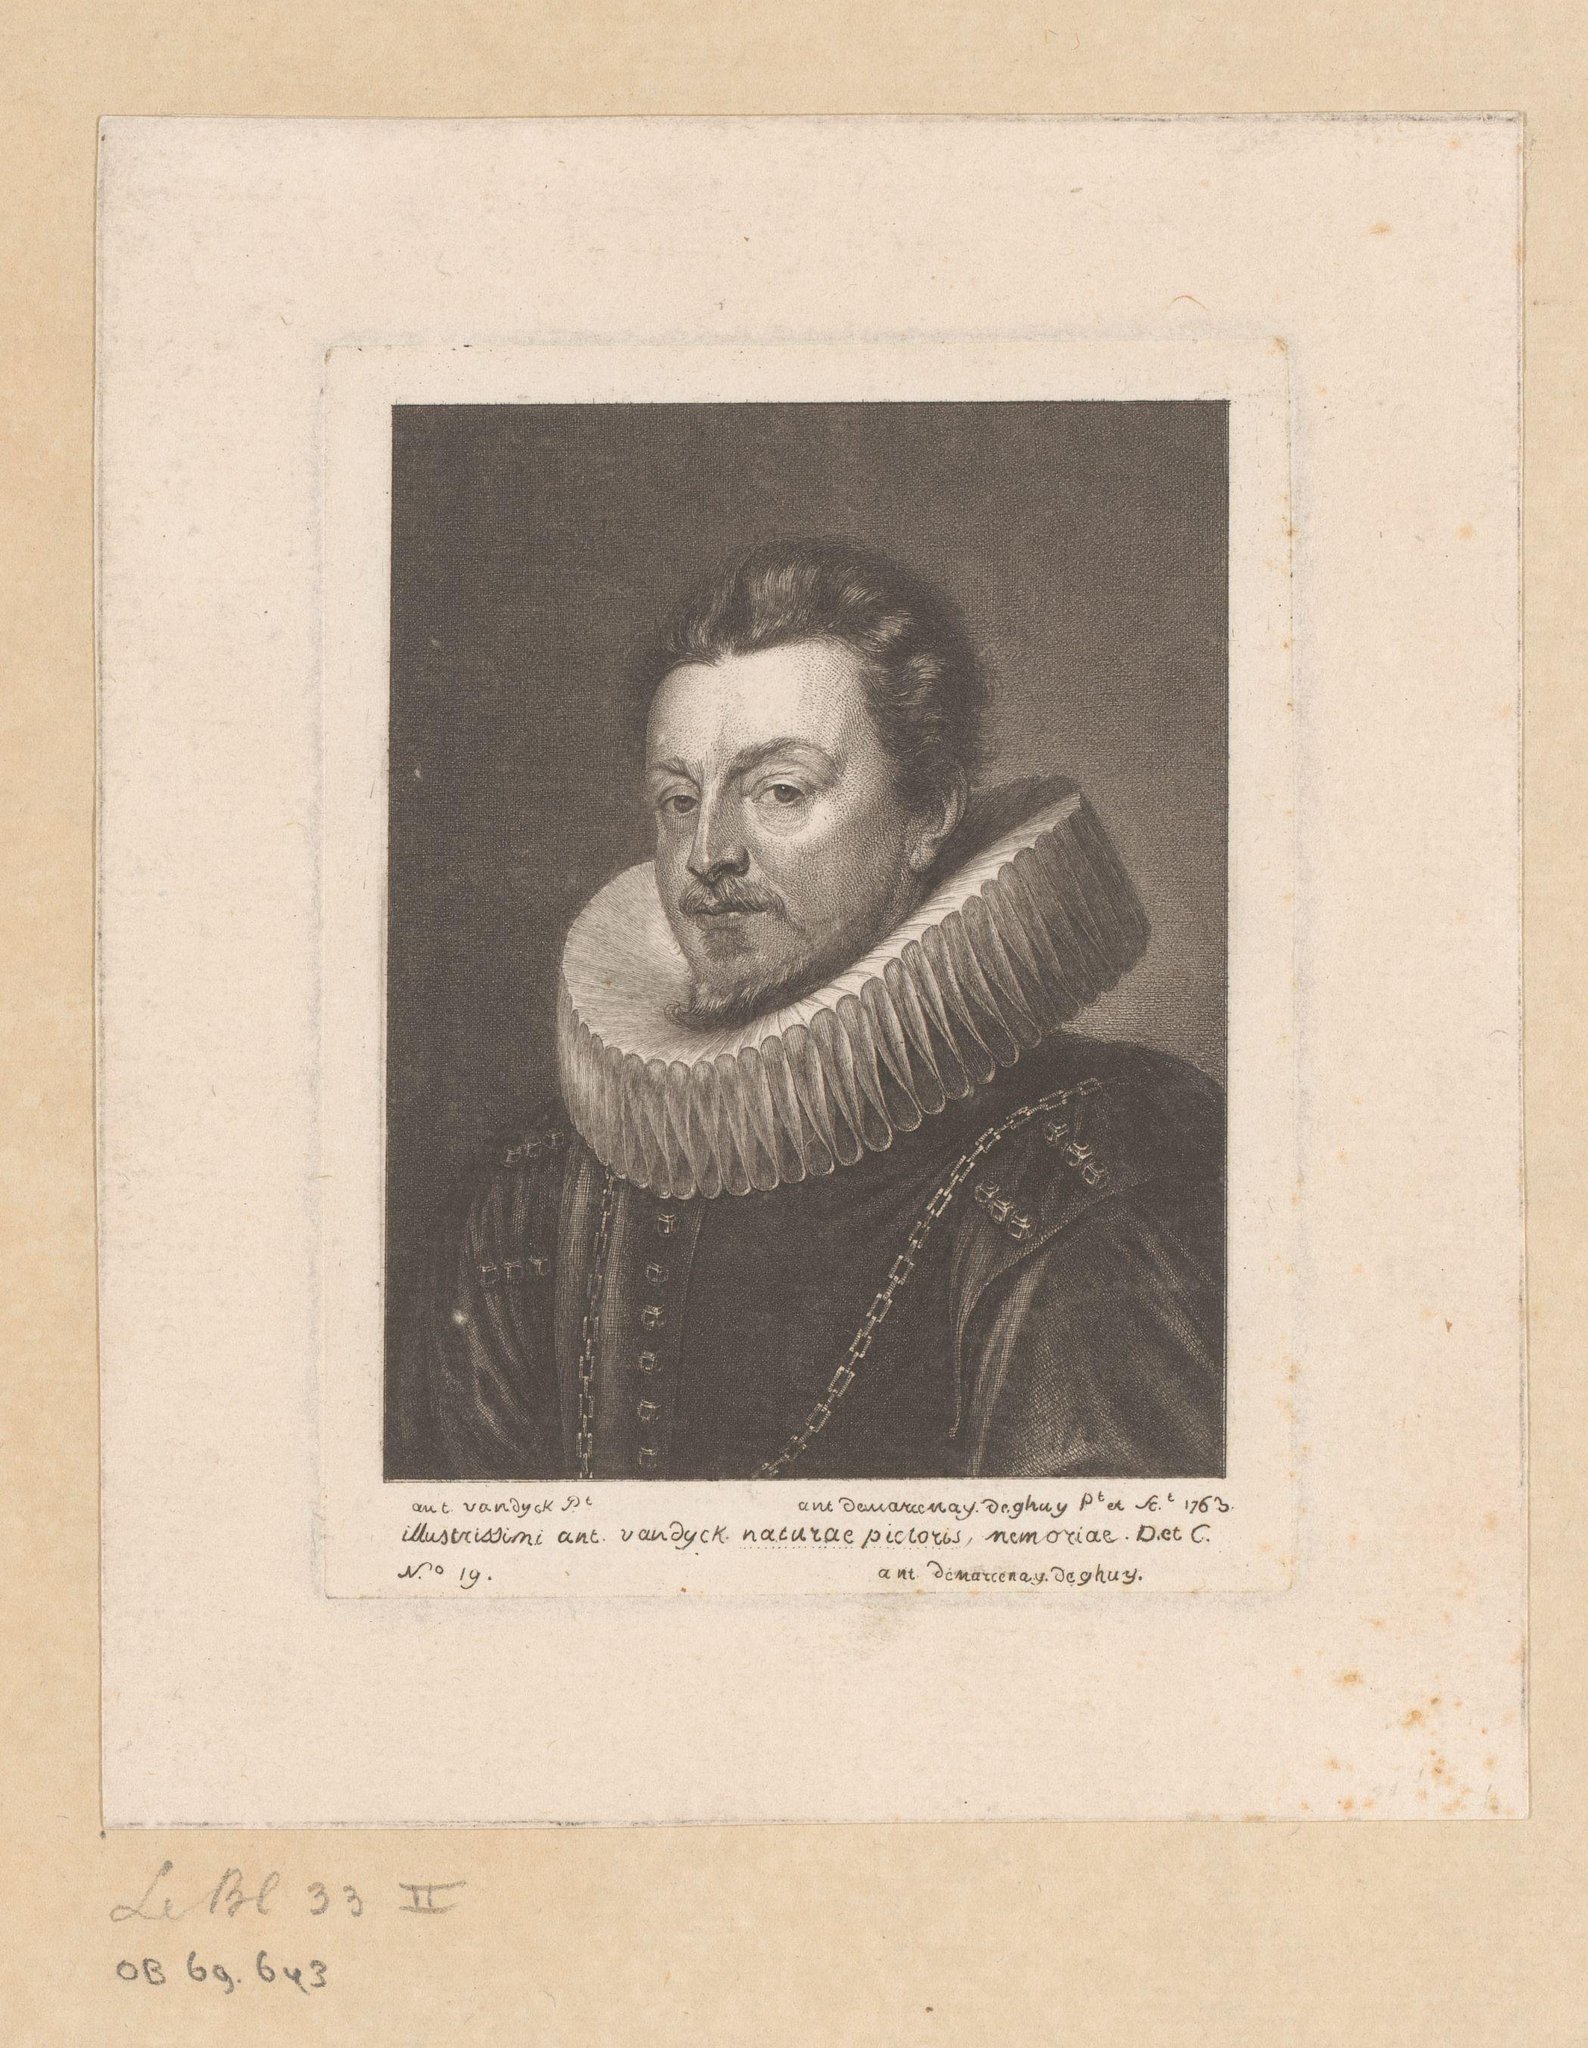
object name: print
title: Portret van een onbekende edelman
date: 1763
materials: paper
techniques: etching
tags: historical persons, neck-gear: collar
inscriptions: collector's mark: Lugt 240